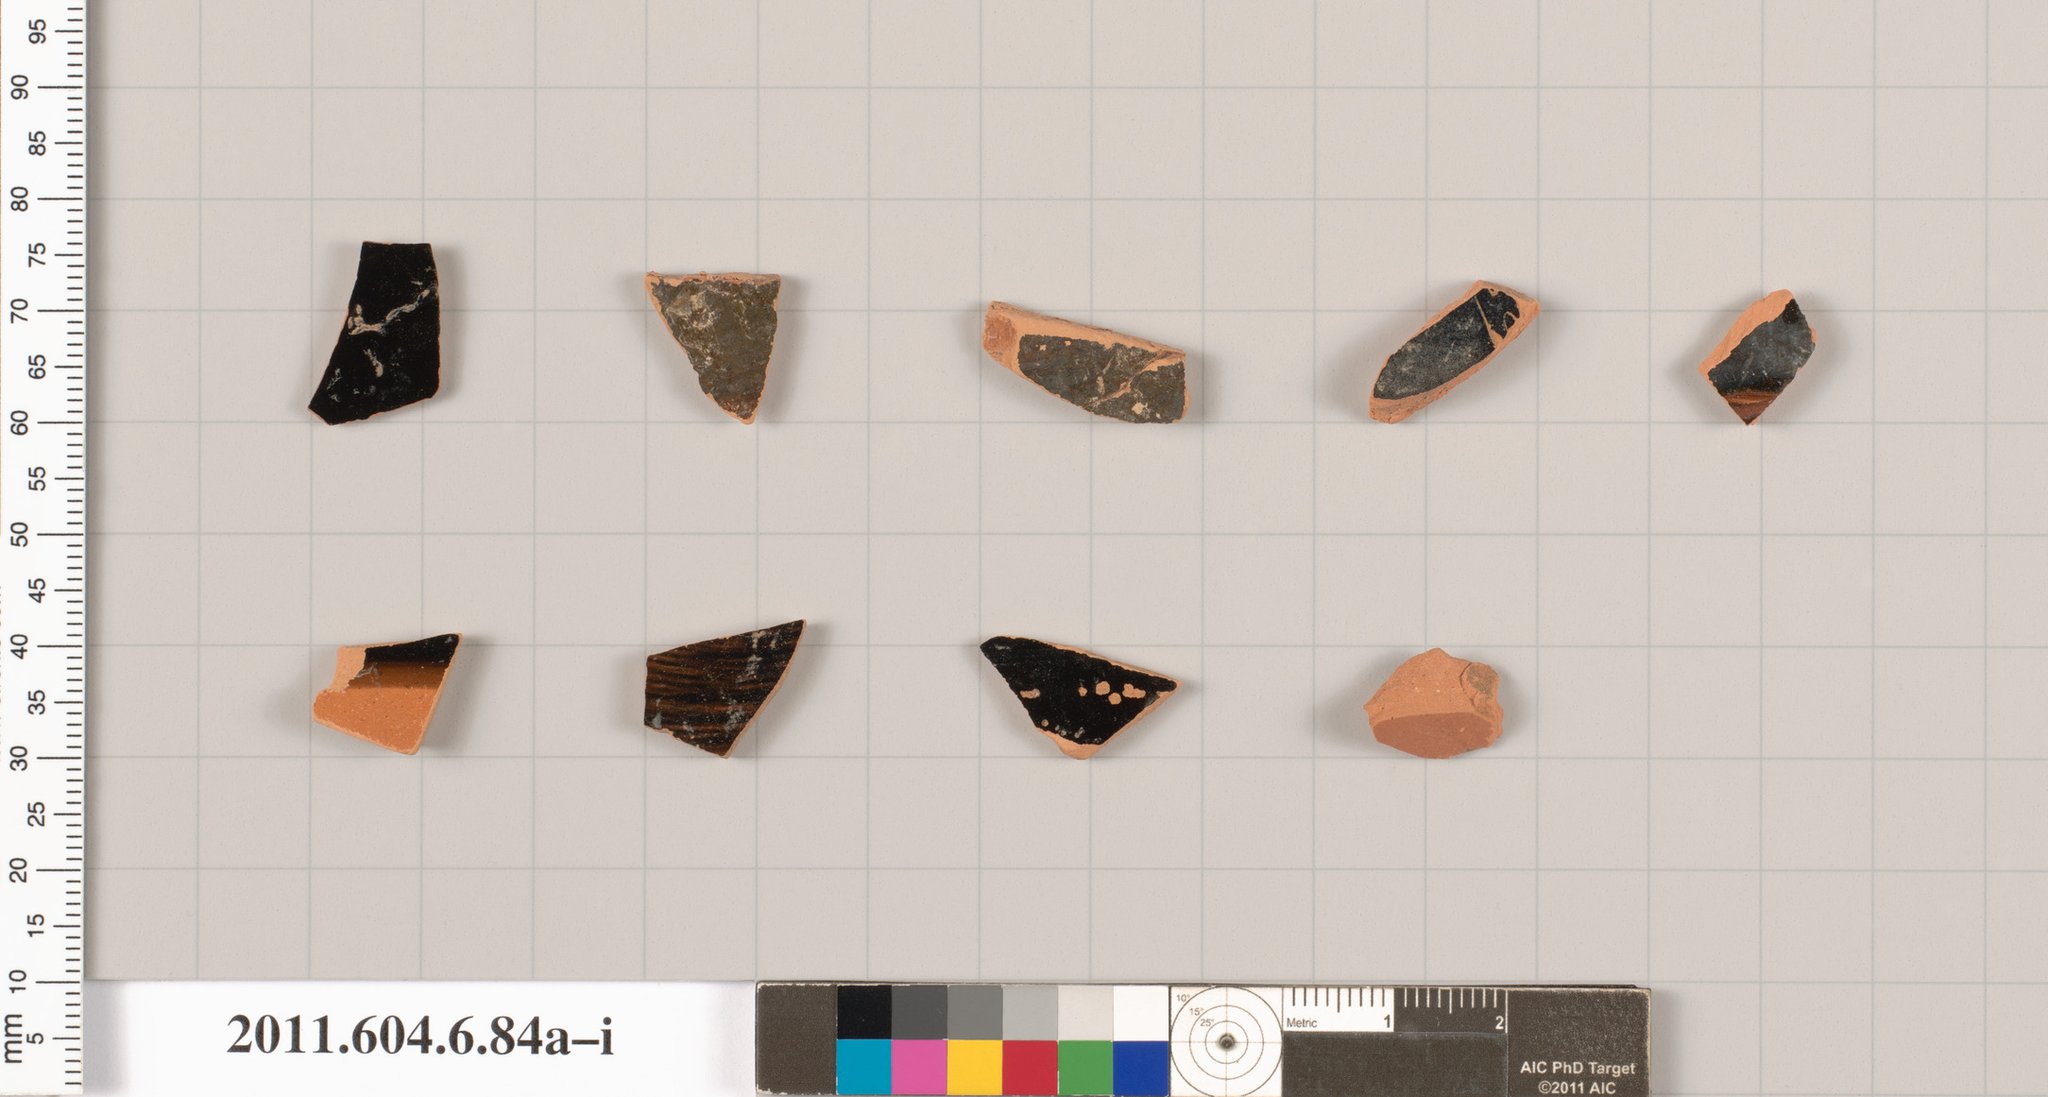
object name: undetermined shape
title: Terracotta fragments of undetermined shapes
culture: greek, attic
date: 600-401 BCE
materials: terracotta